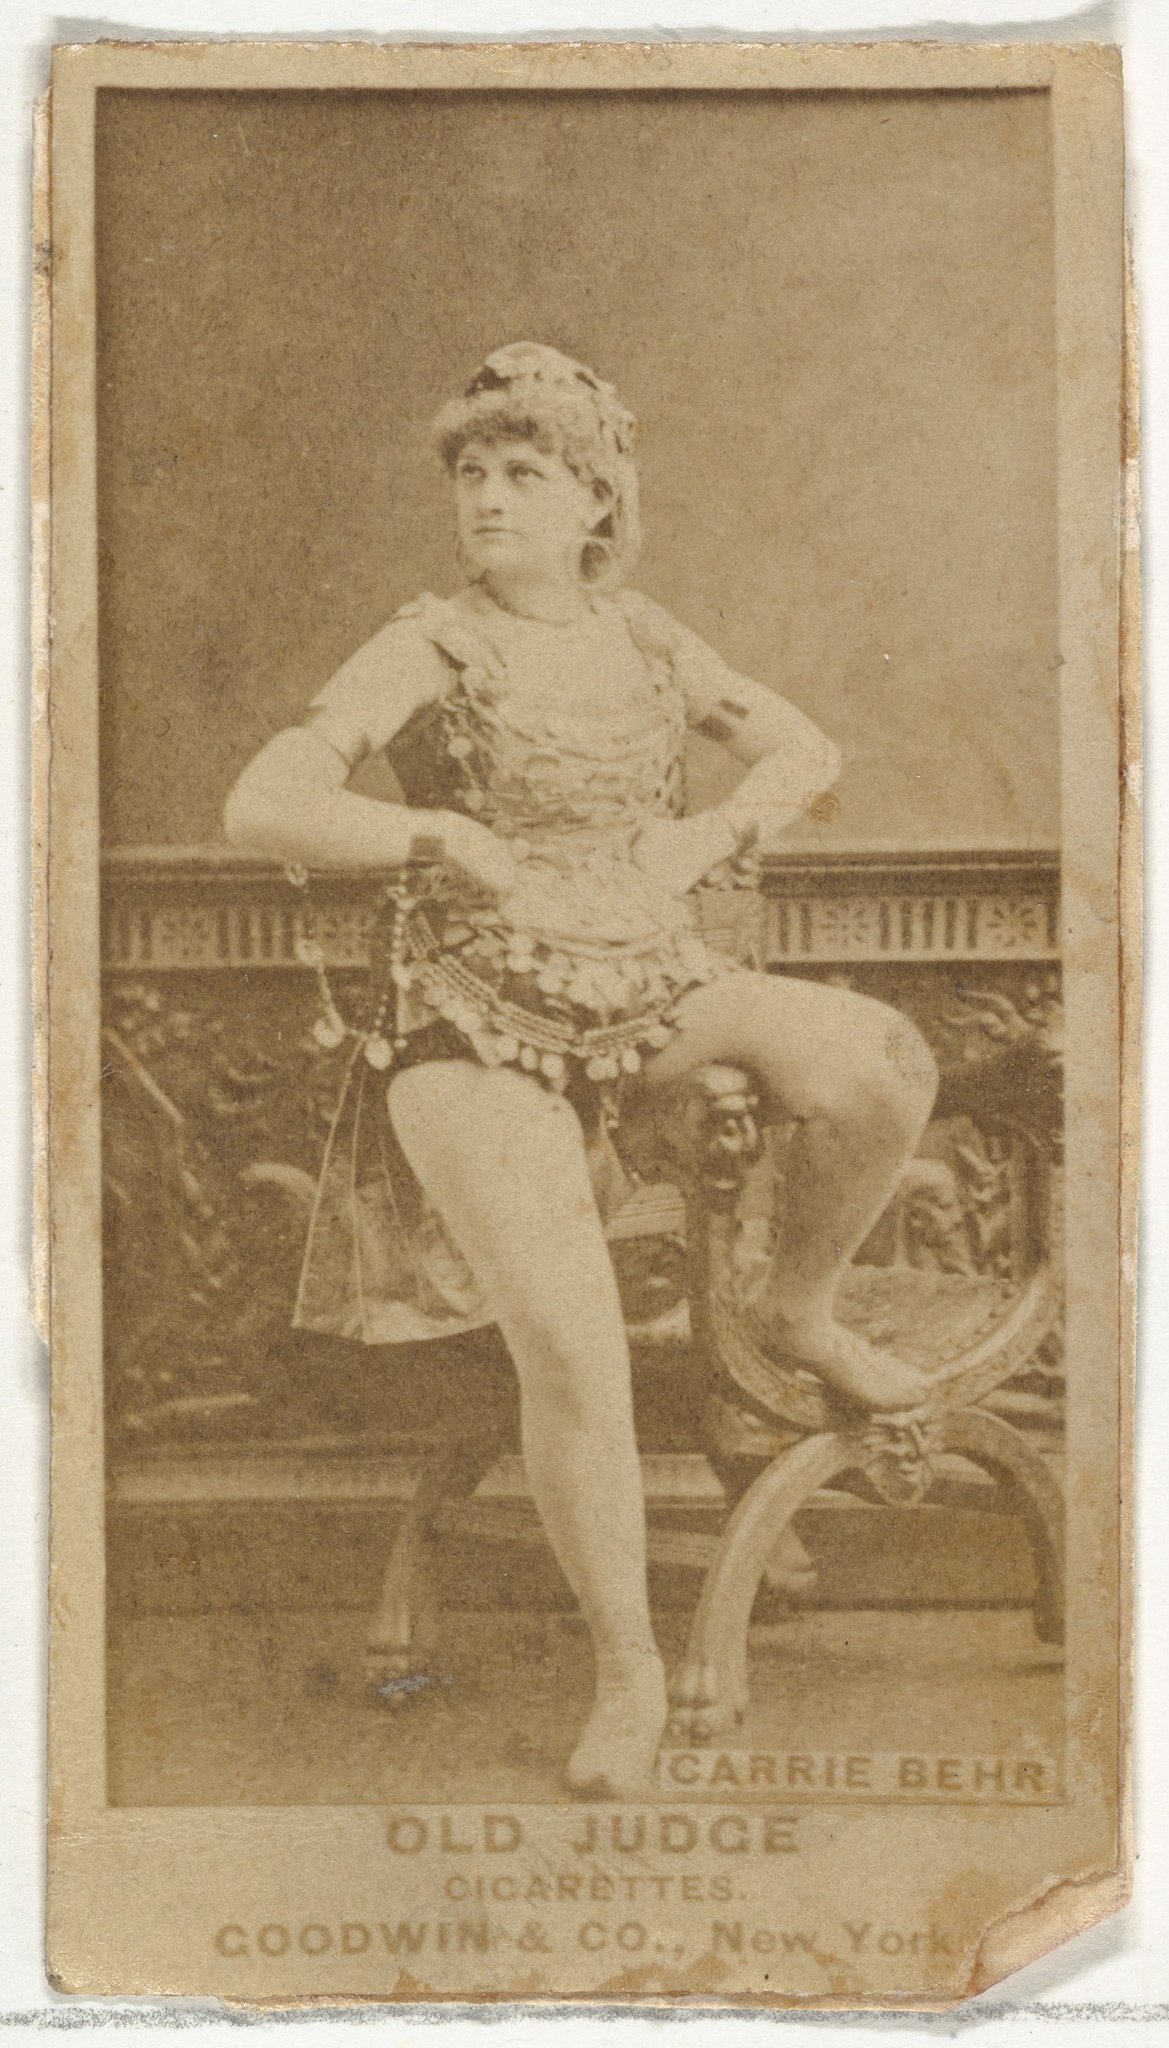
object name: photograph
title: Carrie Behr, from the Actors and Actresses series (N171) for Old Judge Cigarettes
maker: goodwin & company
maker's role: publisher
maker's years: 1850-1950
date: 1886-1890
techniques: albumen silver print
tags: portraits,women,actresses